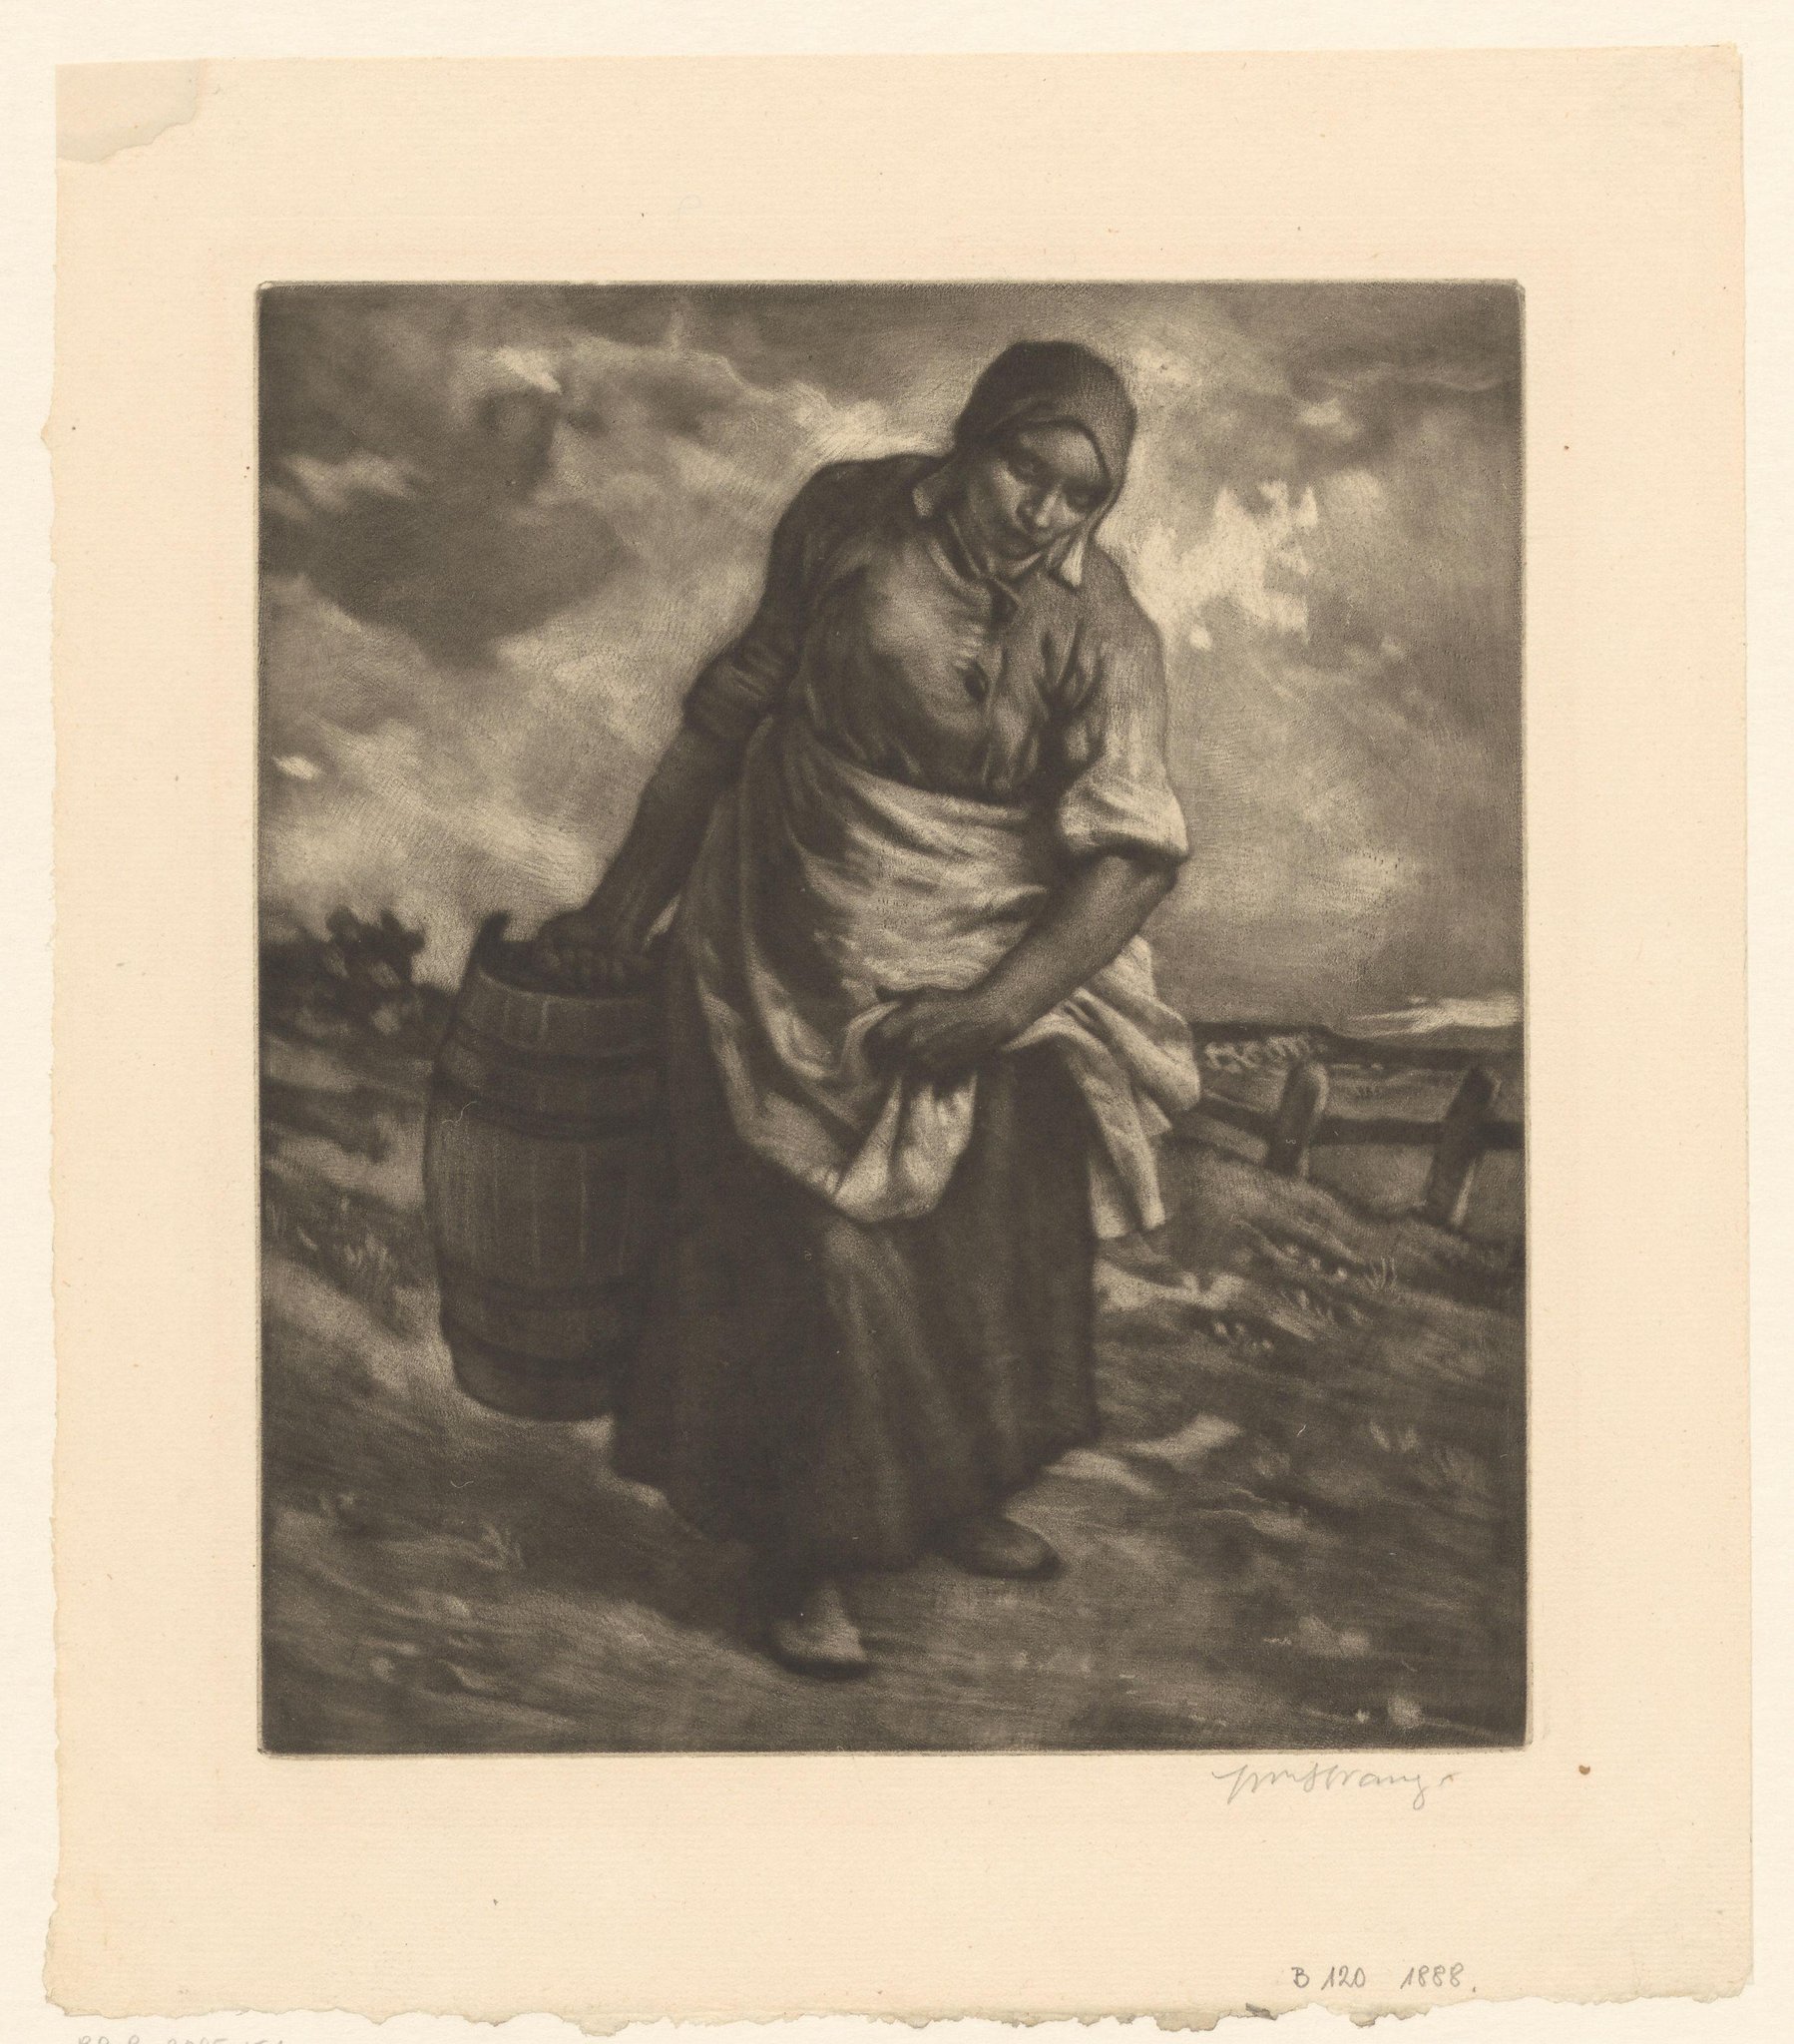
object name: print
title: Death and the Ploughmans wife: a ballad made & etched by William Strang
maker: william strang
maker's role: print maker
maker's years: 1859-1921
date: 1892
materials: paper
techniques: mezzotint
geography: london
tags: farmers, carrying something in basket, bag, rucksack, etc.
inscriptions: signature: ‘WmStrang’